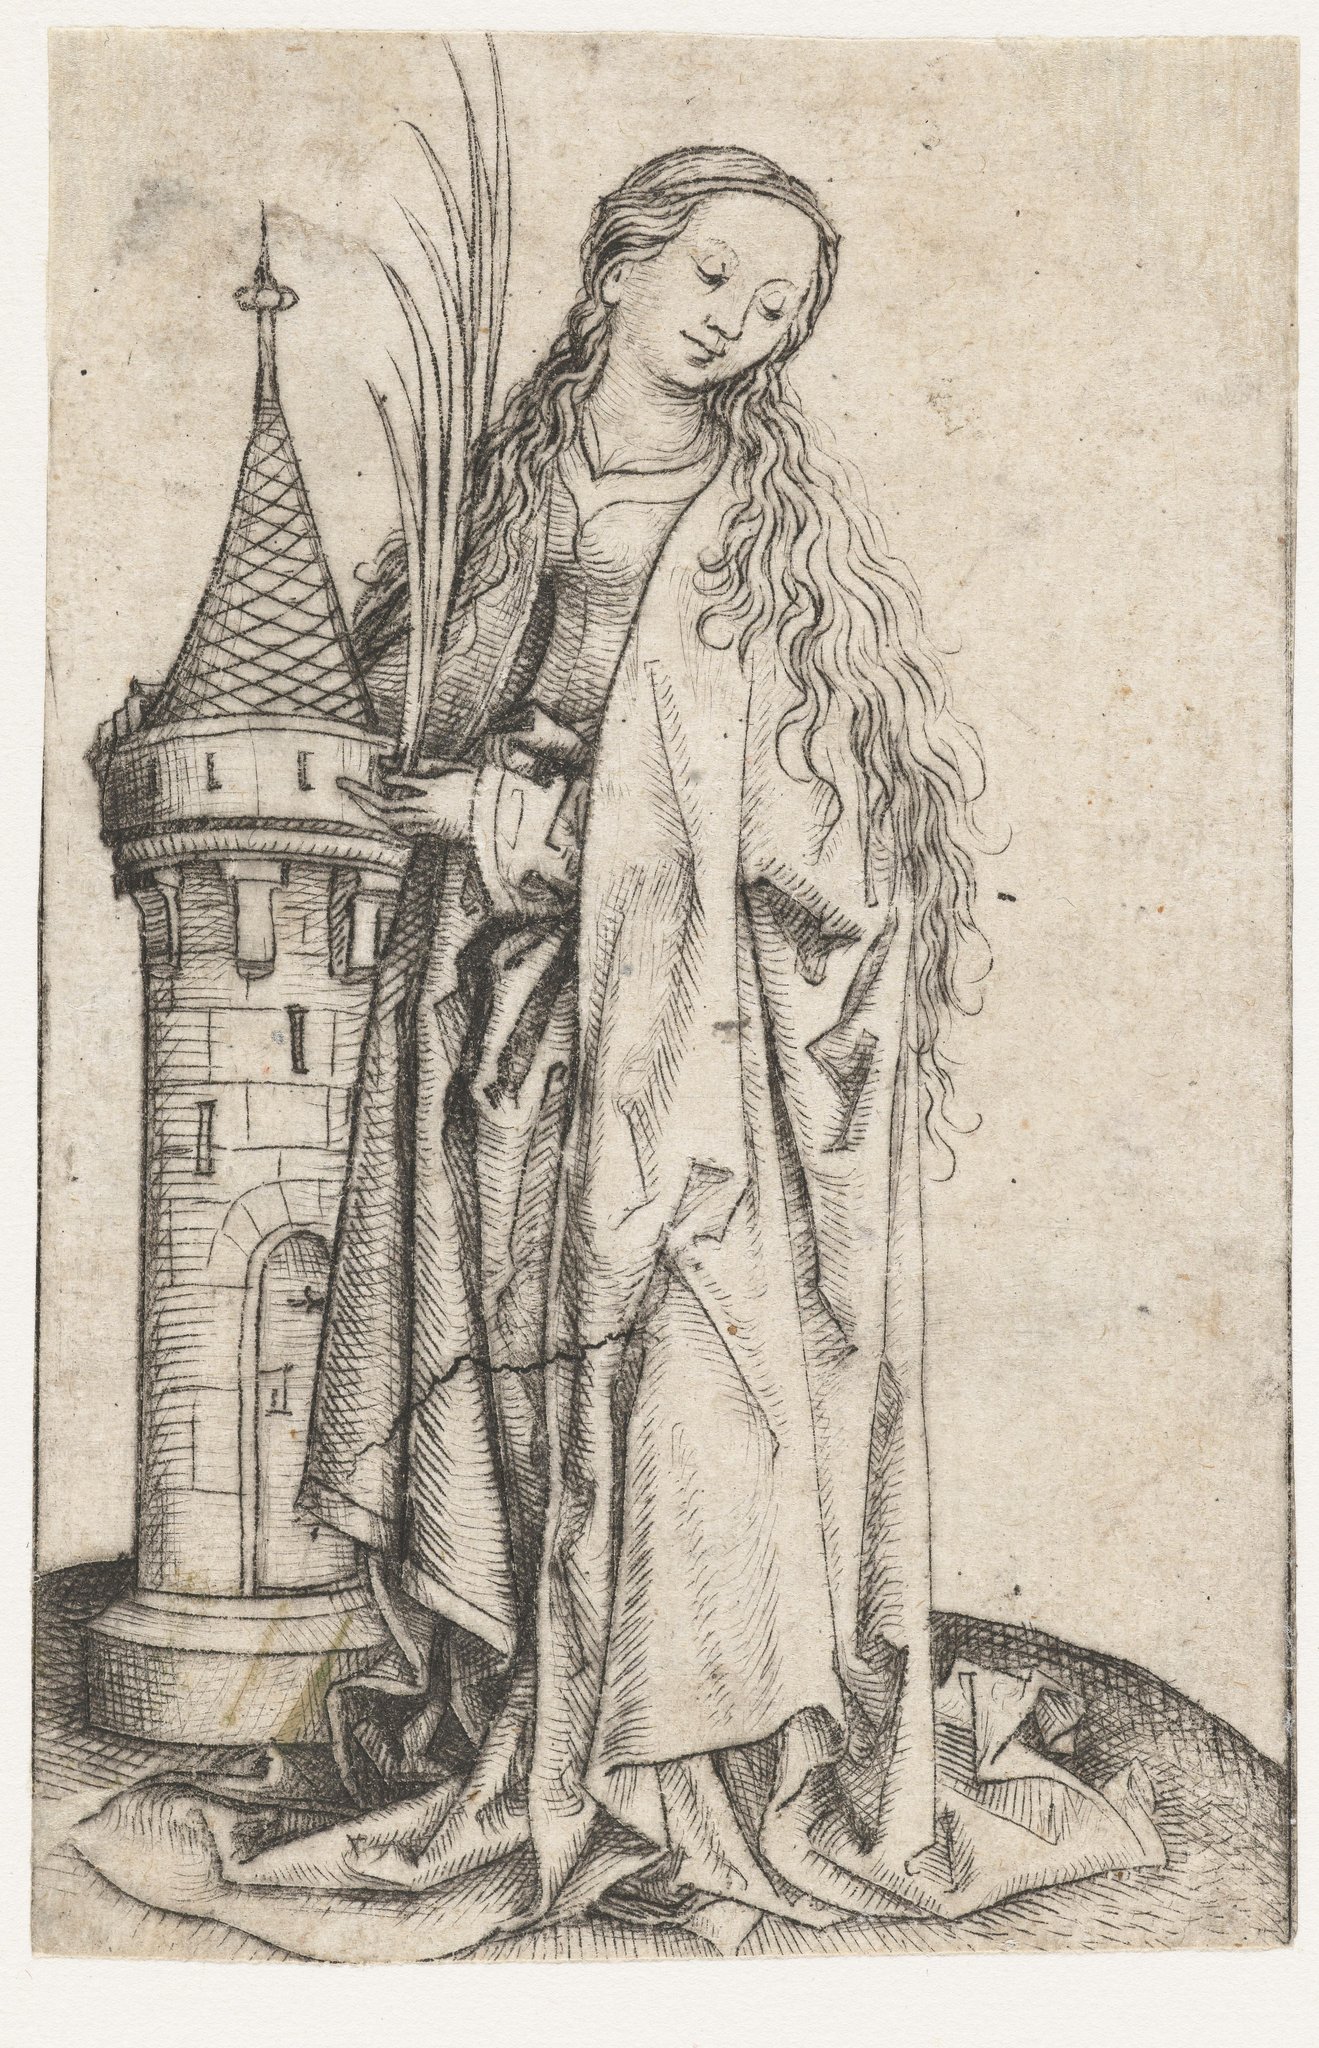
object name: print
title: Heilige Barbara (grote versie)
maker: meester van het amsterdamse kabinet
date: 1470-1475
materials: paper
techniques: drypoint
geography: germany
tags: the virgin martyr barbara; possible attributes: book, cannon(ball), crown, cross, chalice with wafer, dioscuros (her father), peacock feather, sword, torches, mason's tools, tower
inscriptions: collector's mark: Lugt 2228a